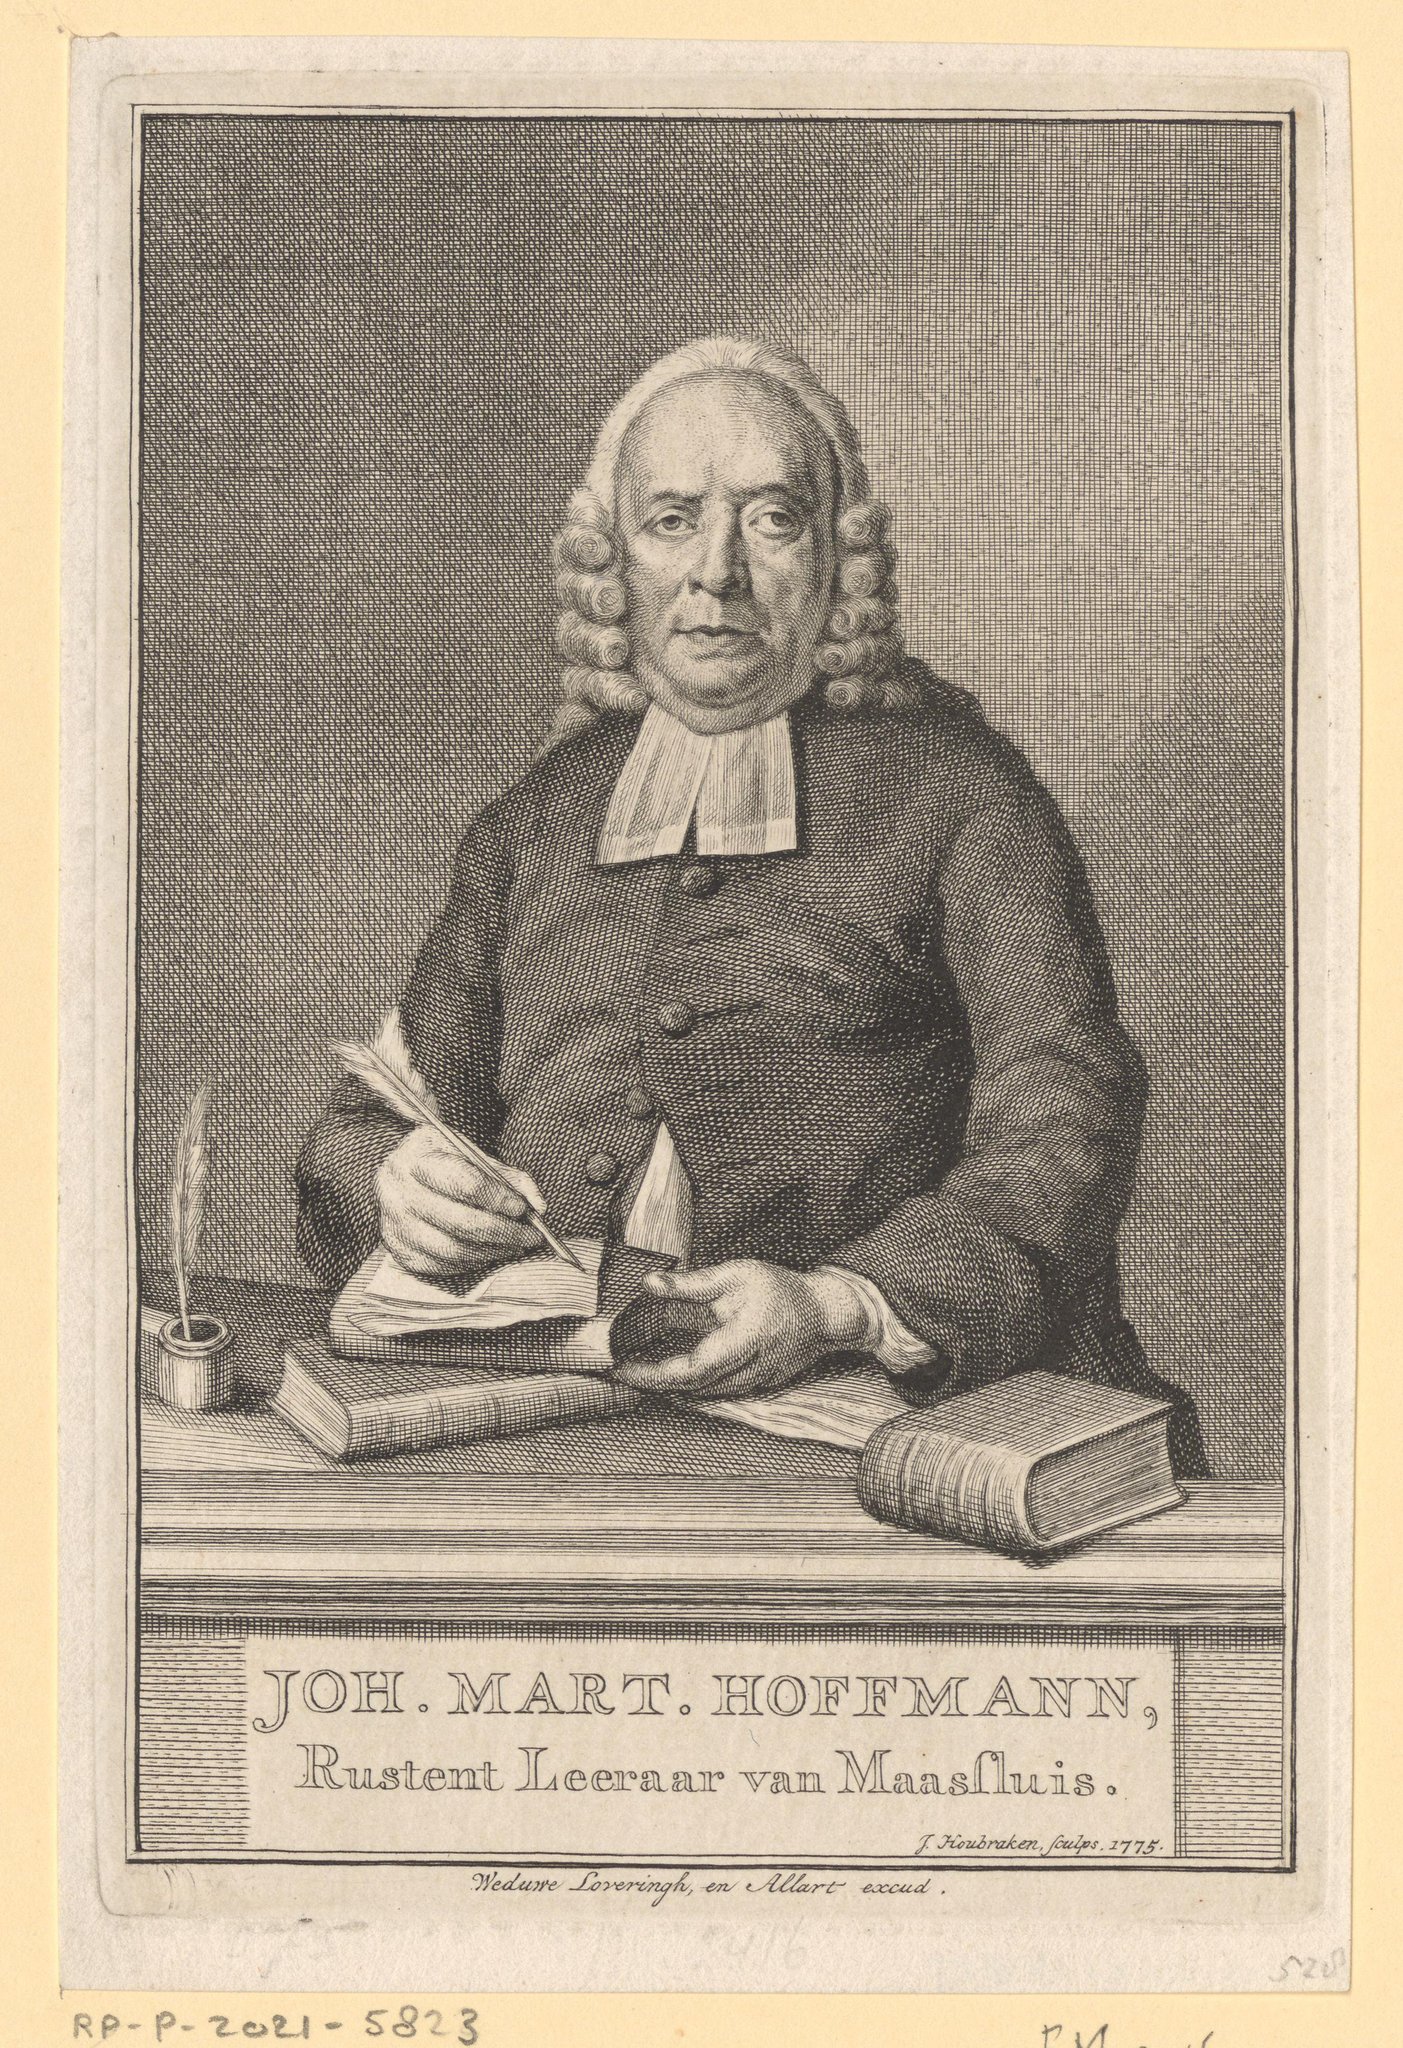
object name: print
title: Portret van Johannes Martinus Hoffman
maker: jacob houbraken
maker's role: draughtsman, print maker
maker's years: 1698-1780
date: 1775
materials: paper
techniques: engraving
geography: amsterdam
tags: historical persons, book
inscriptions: date